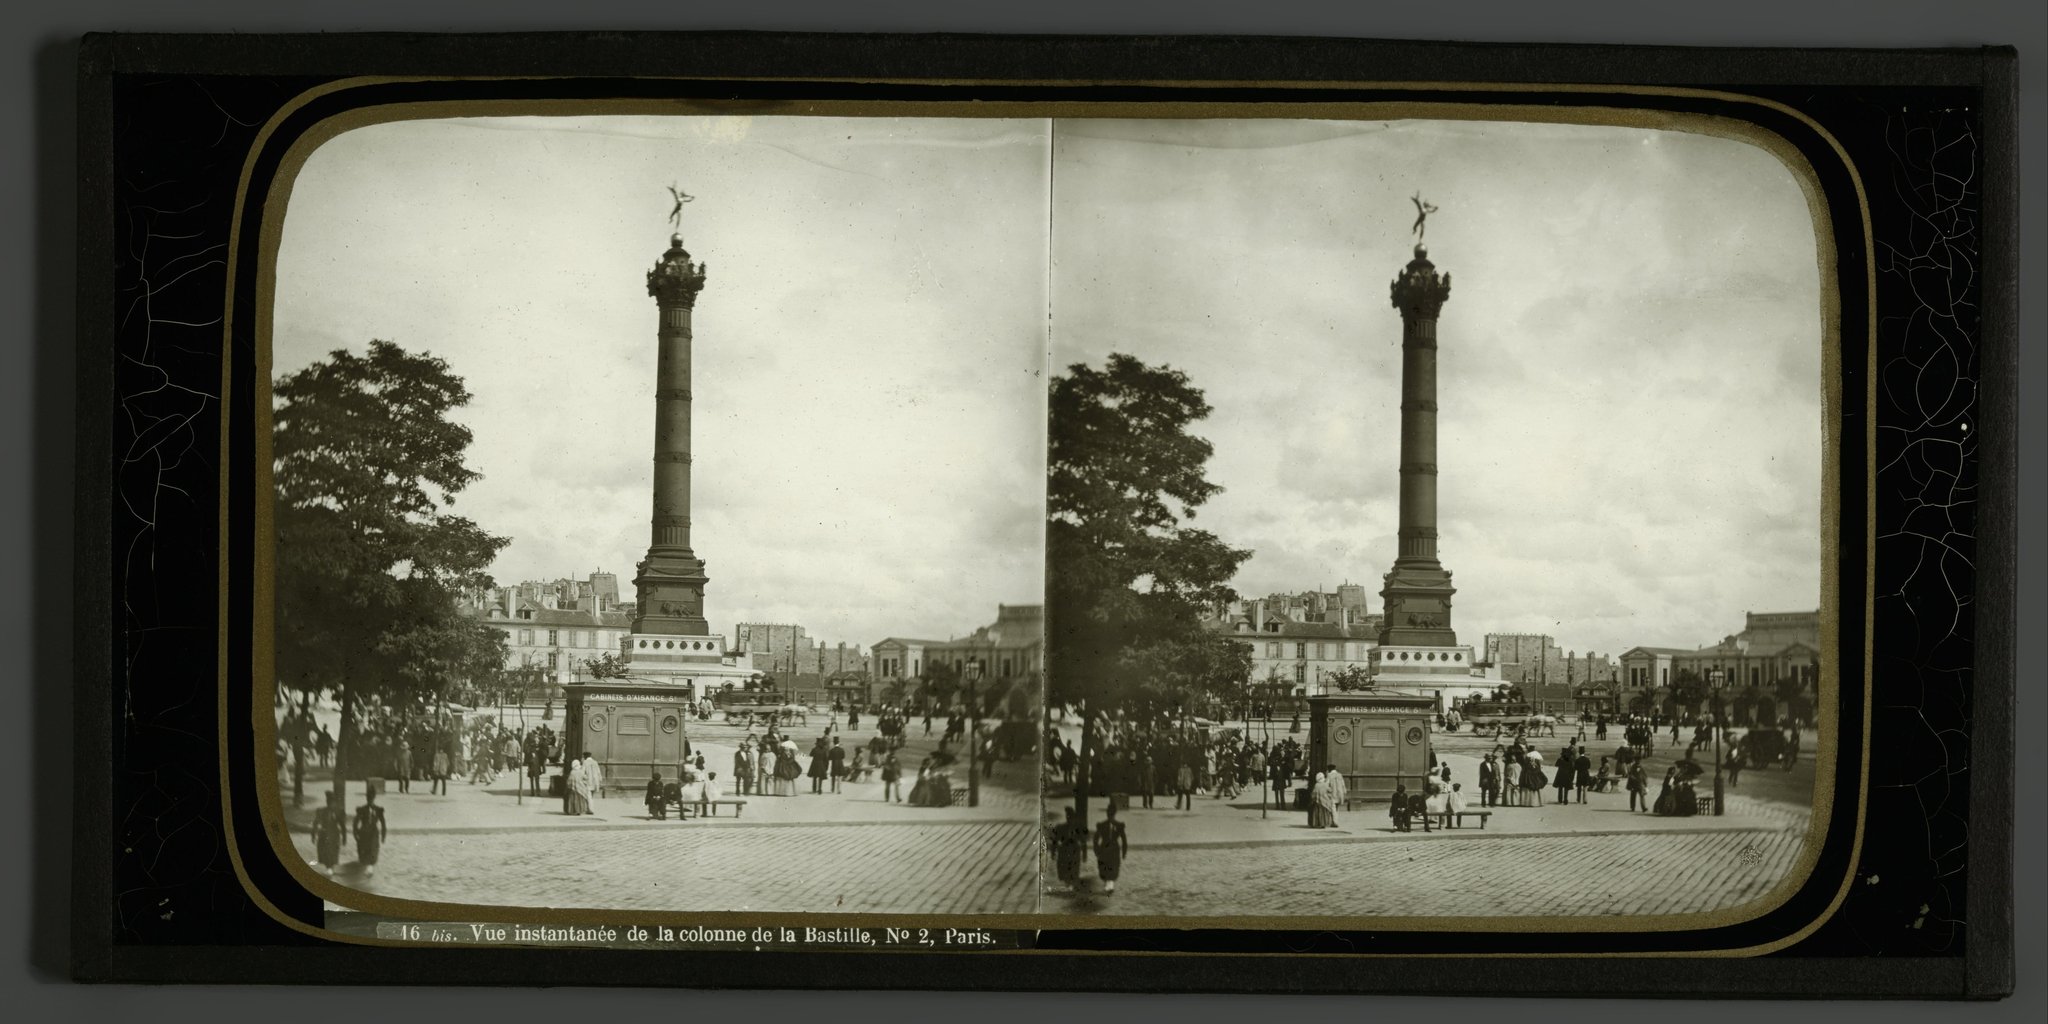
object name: stereoscopic photograph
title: Vue instantanée de la colonne de la Bastille, No 2, Paris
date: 1860-1870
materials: glass, paper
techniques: slide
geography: paris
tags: square, place, circus, etc., triumphal column with helical friezes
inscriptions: number: ‘16 bis’